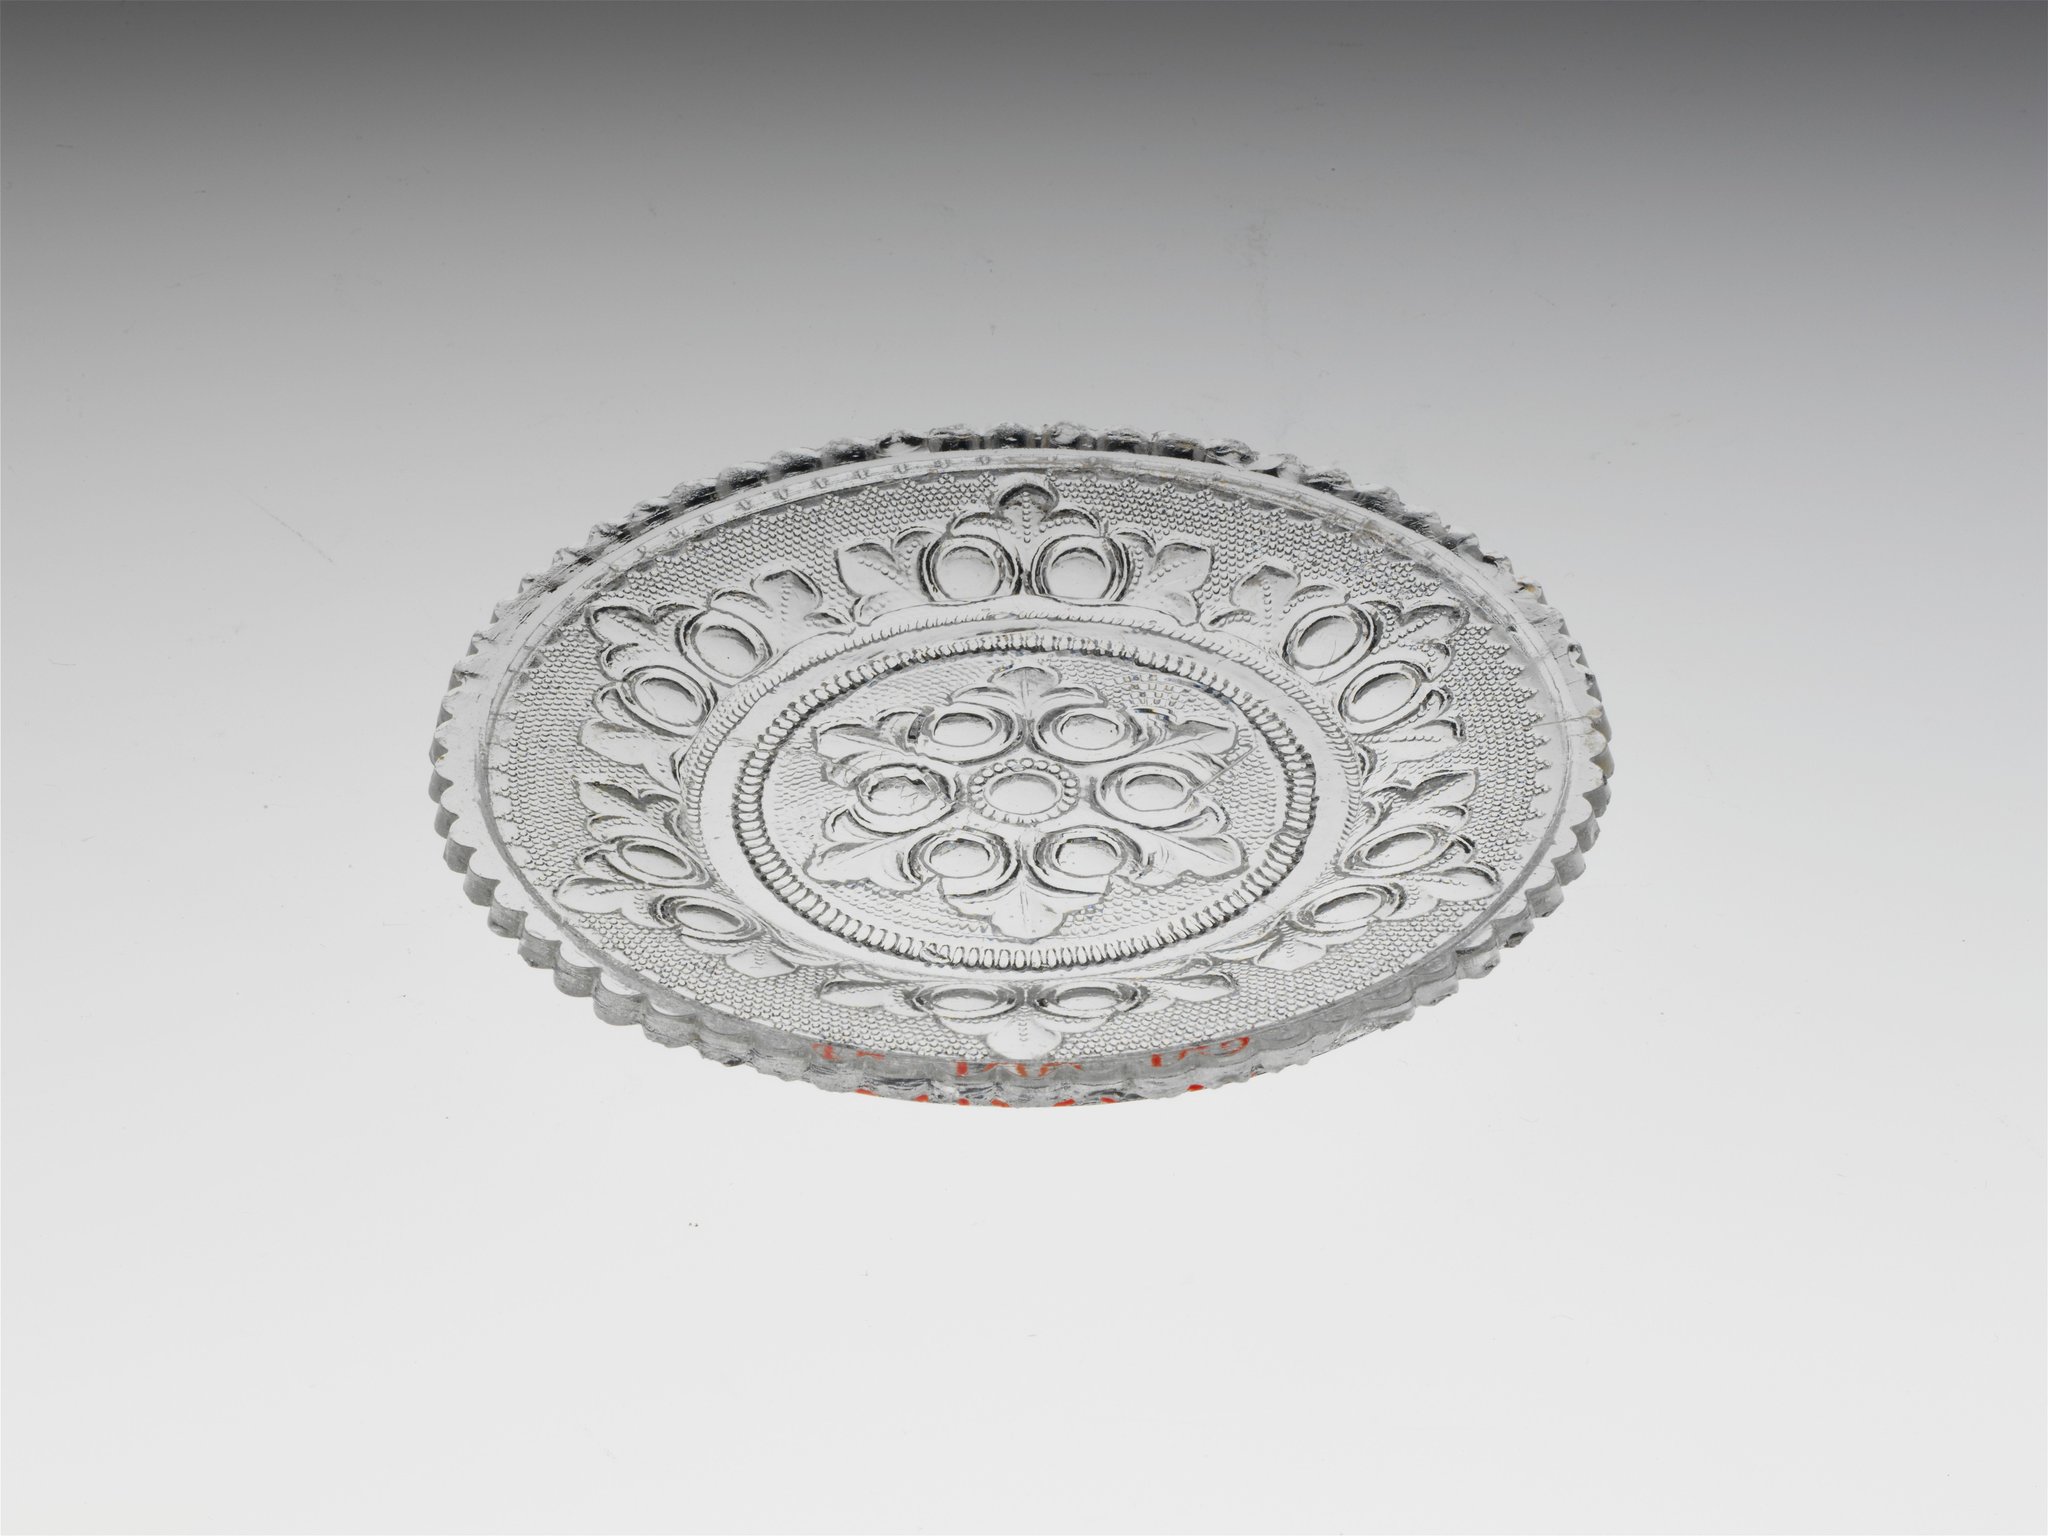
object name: cup plate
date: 1825-1860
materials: glass